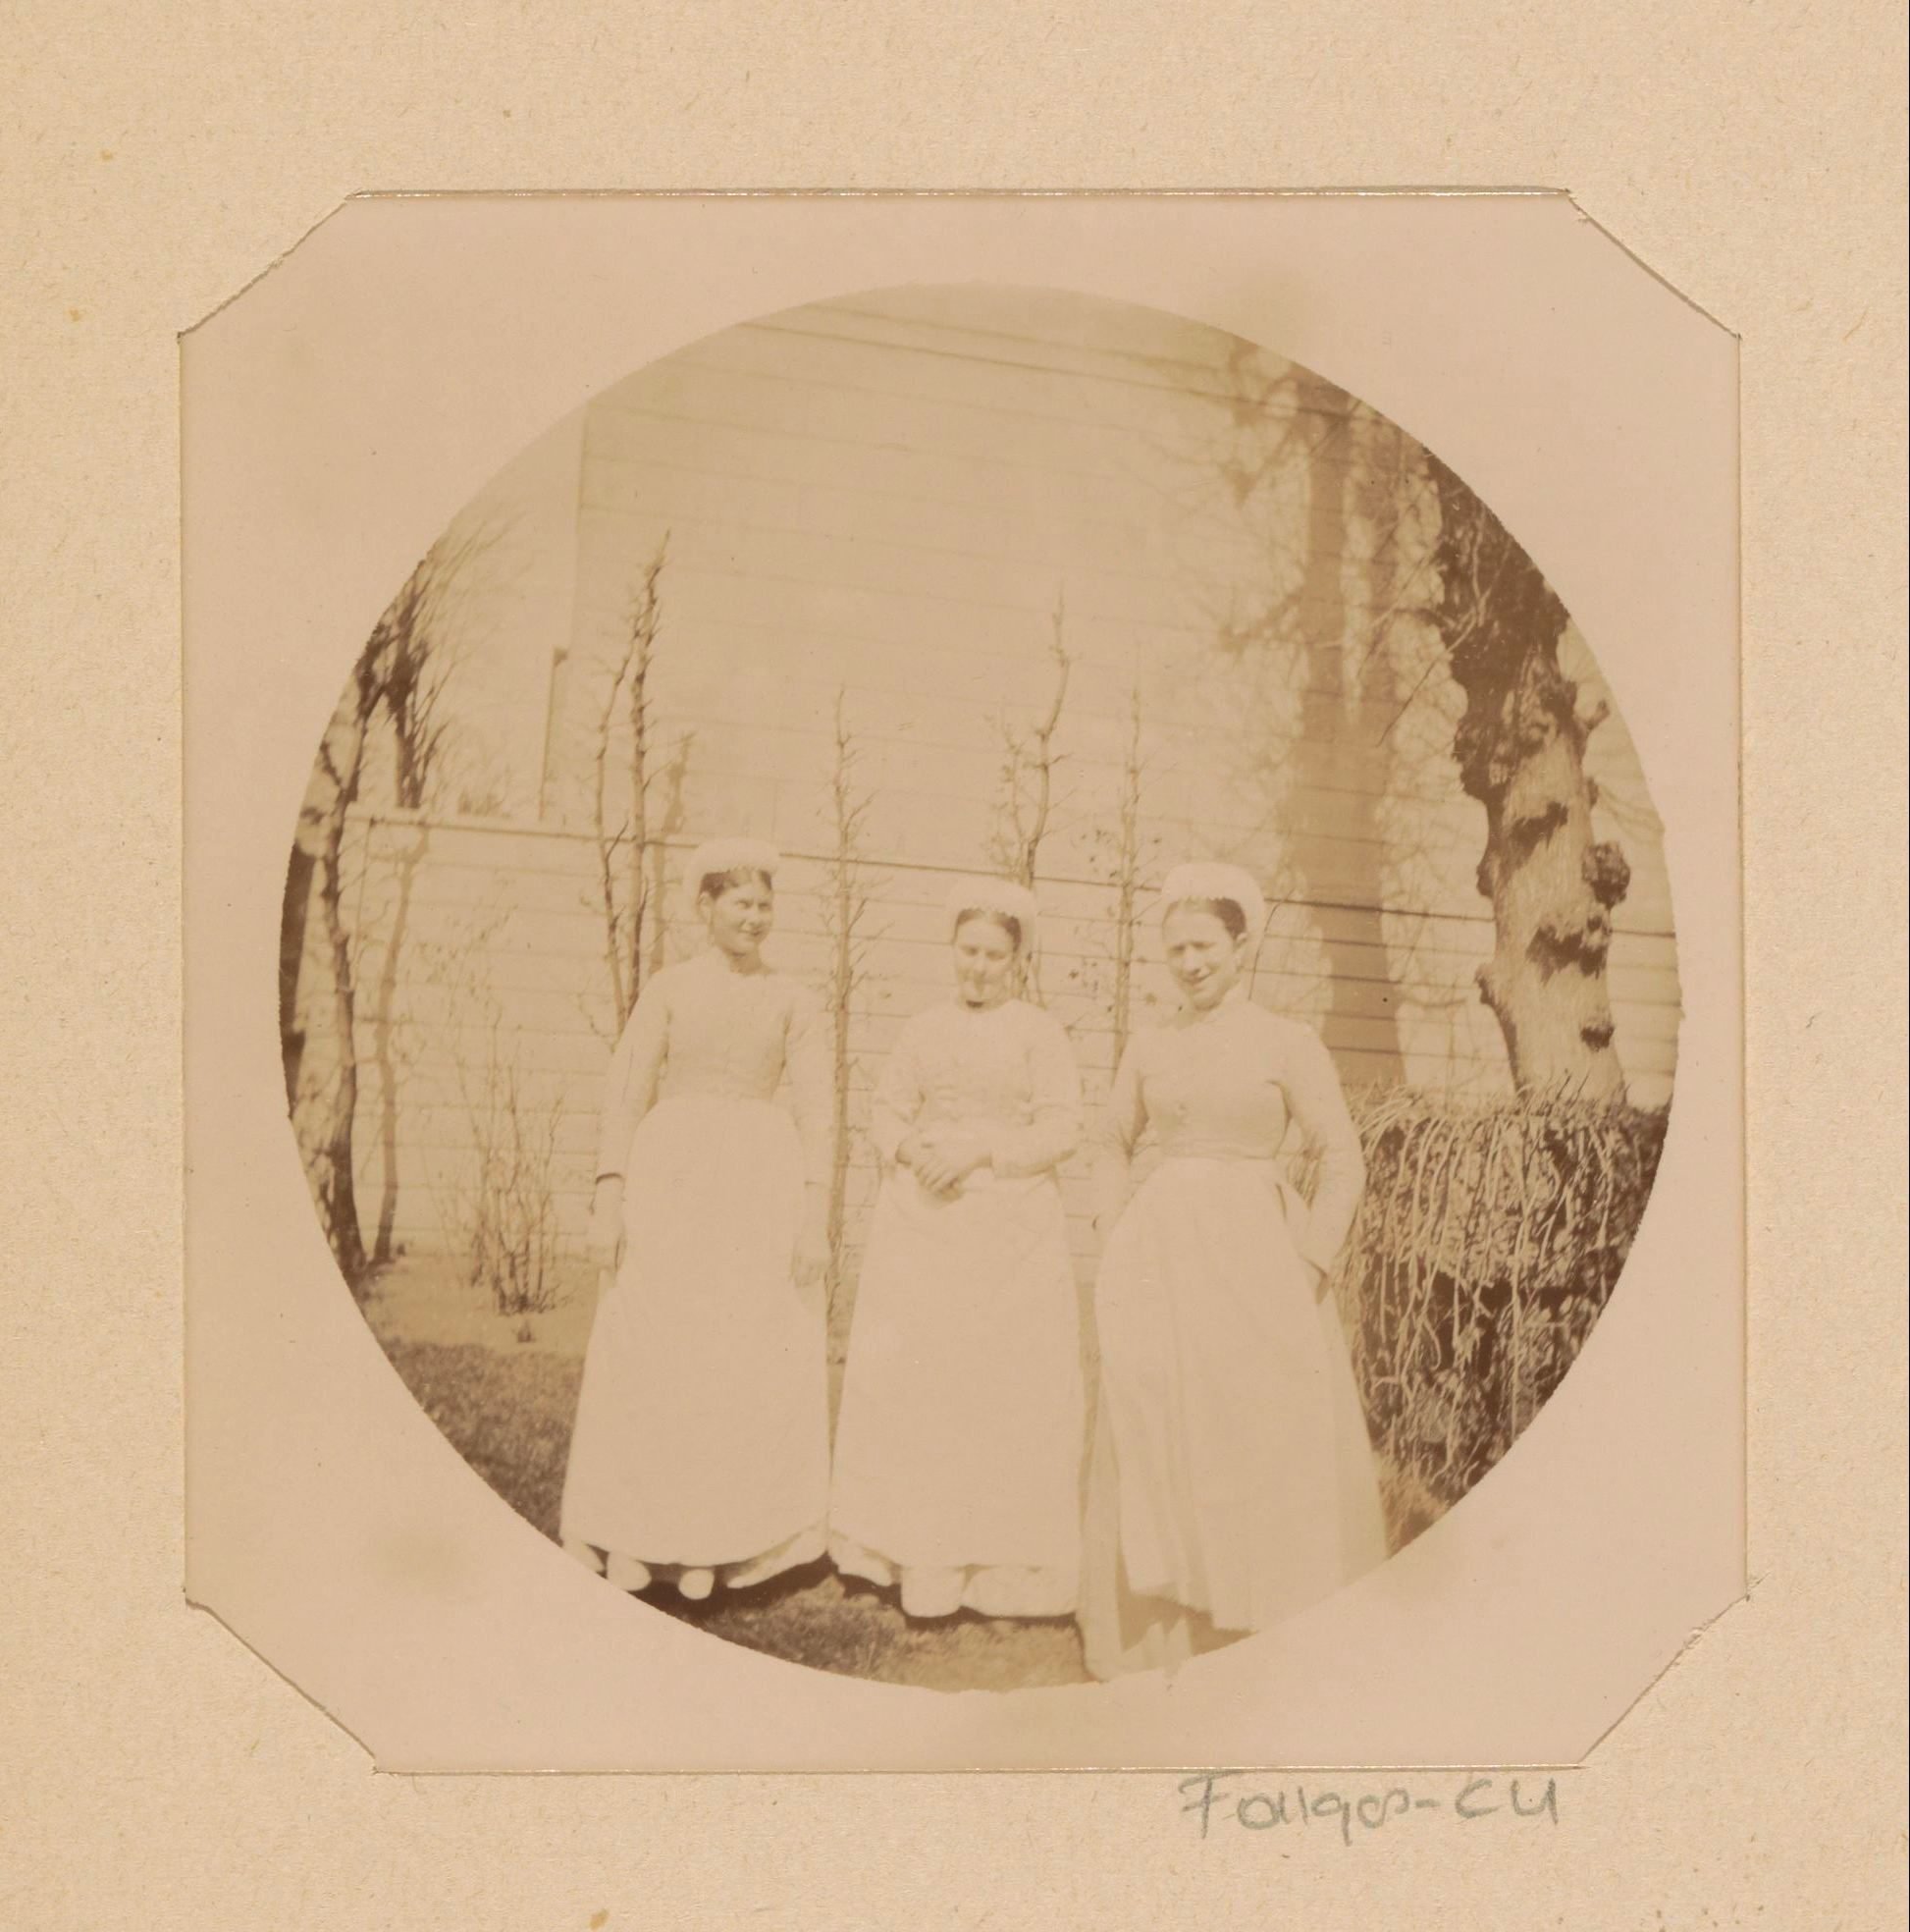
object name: photograph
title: Portret van drie onbekende dienstmeisjes in een tuin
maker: johanna margaretha piek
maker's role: fotograaf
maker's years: 1870-1947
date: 1889-1893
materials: paper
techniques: gelatin silver print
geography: netherlands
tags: anonymous historical person portrayed, maid ~ house personnel, netherlands